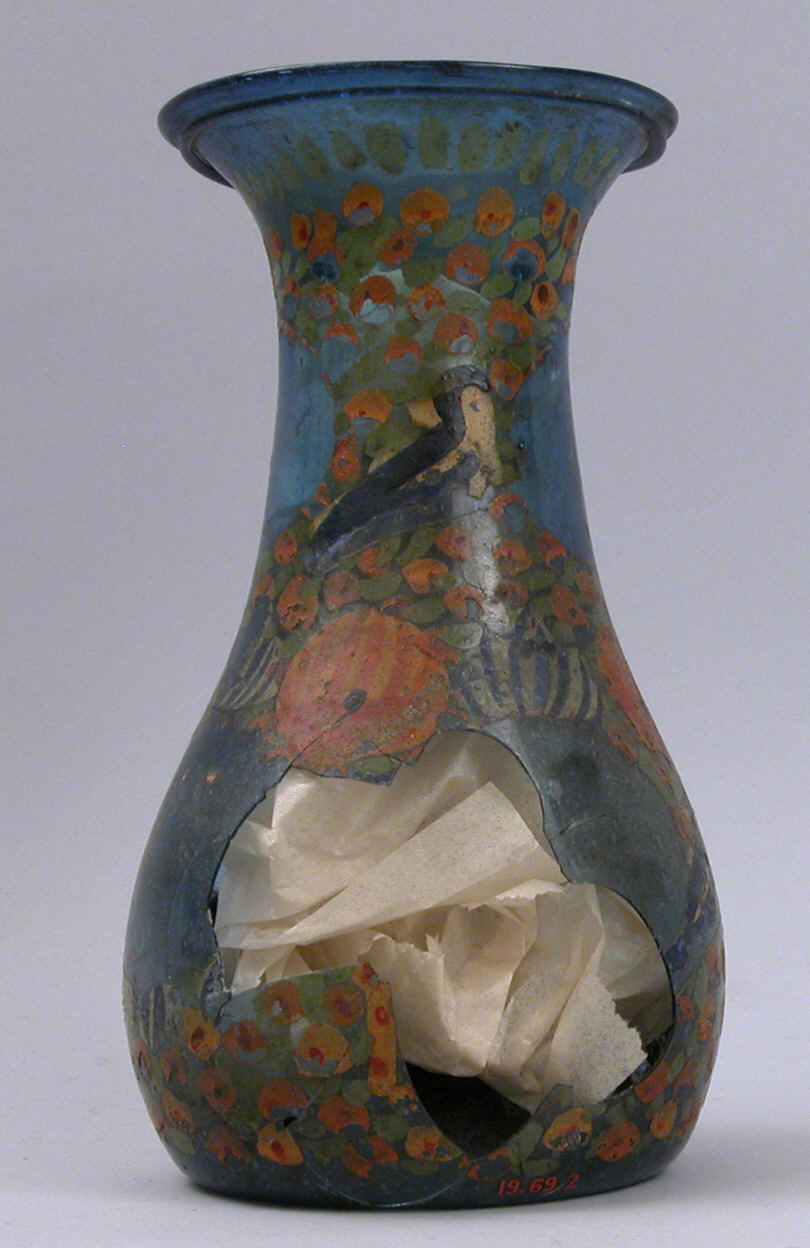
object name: vase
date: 1701-1900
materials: glass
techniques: painting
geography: iran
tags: birds,flowers